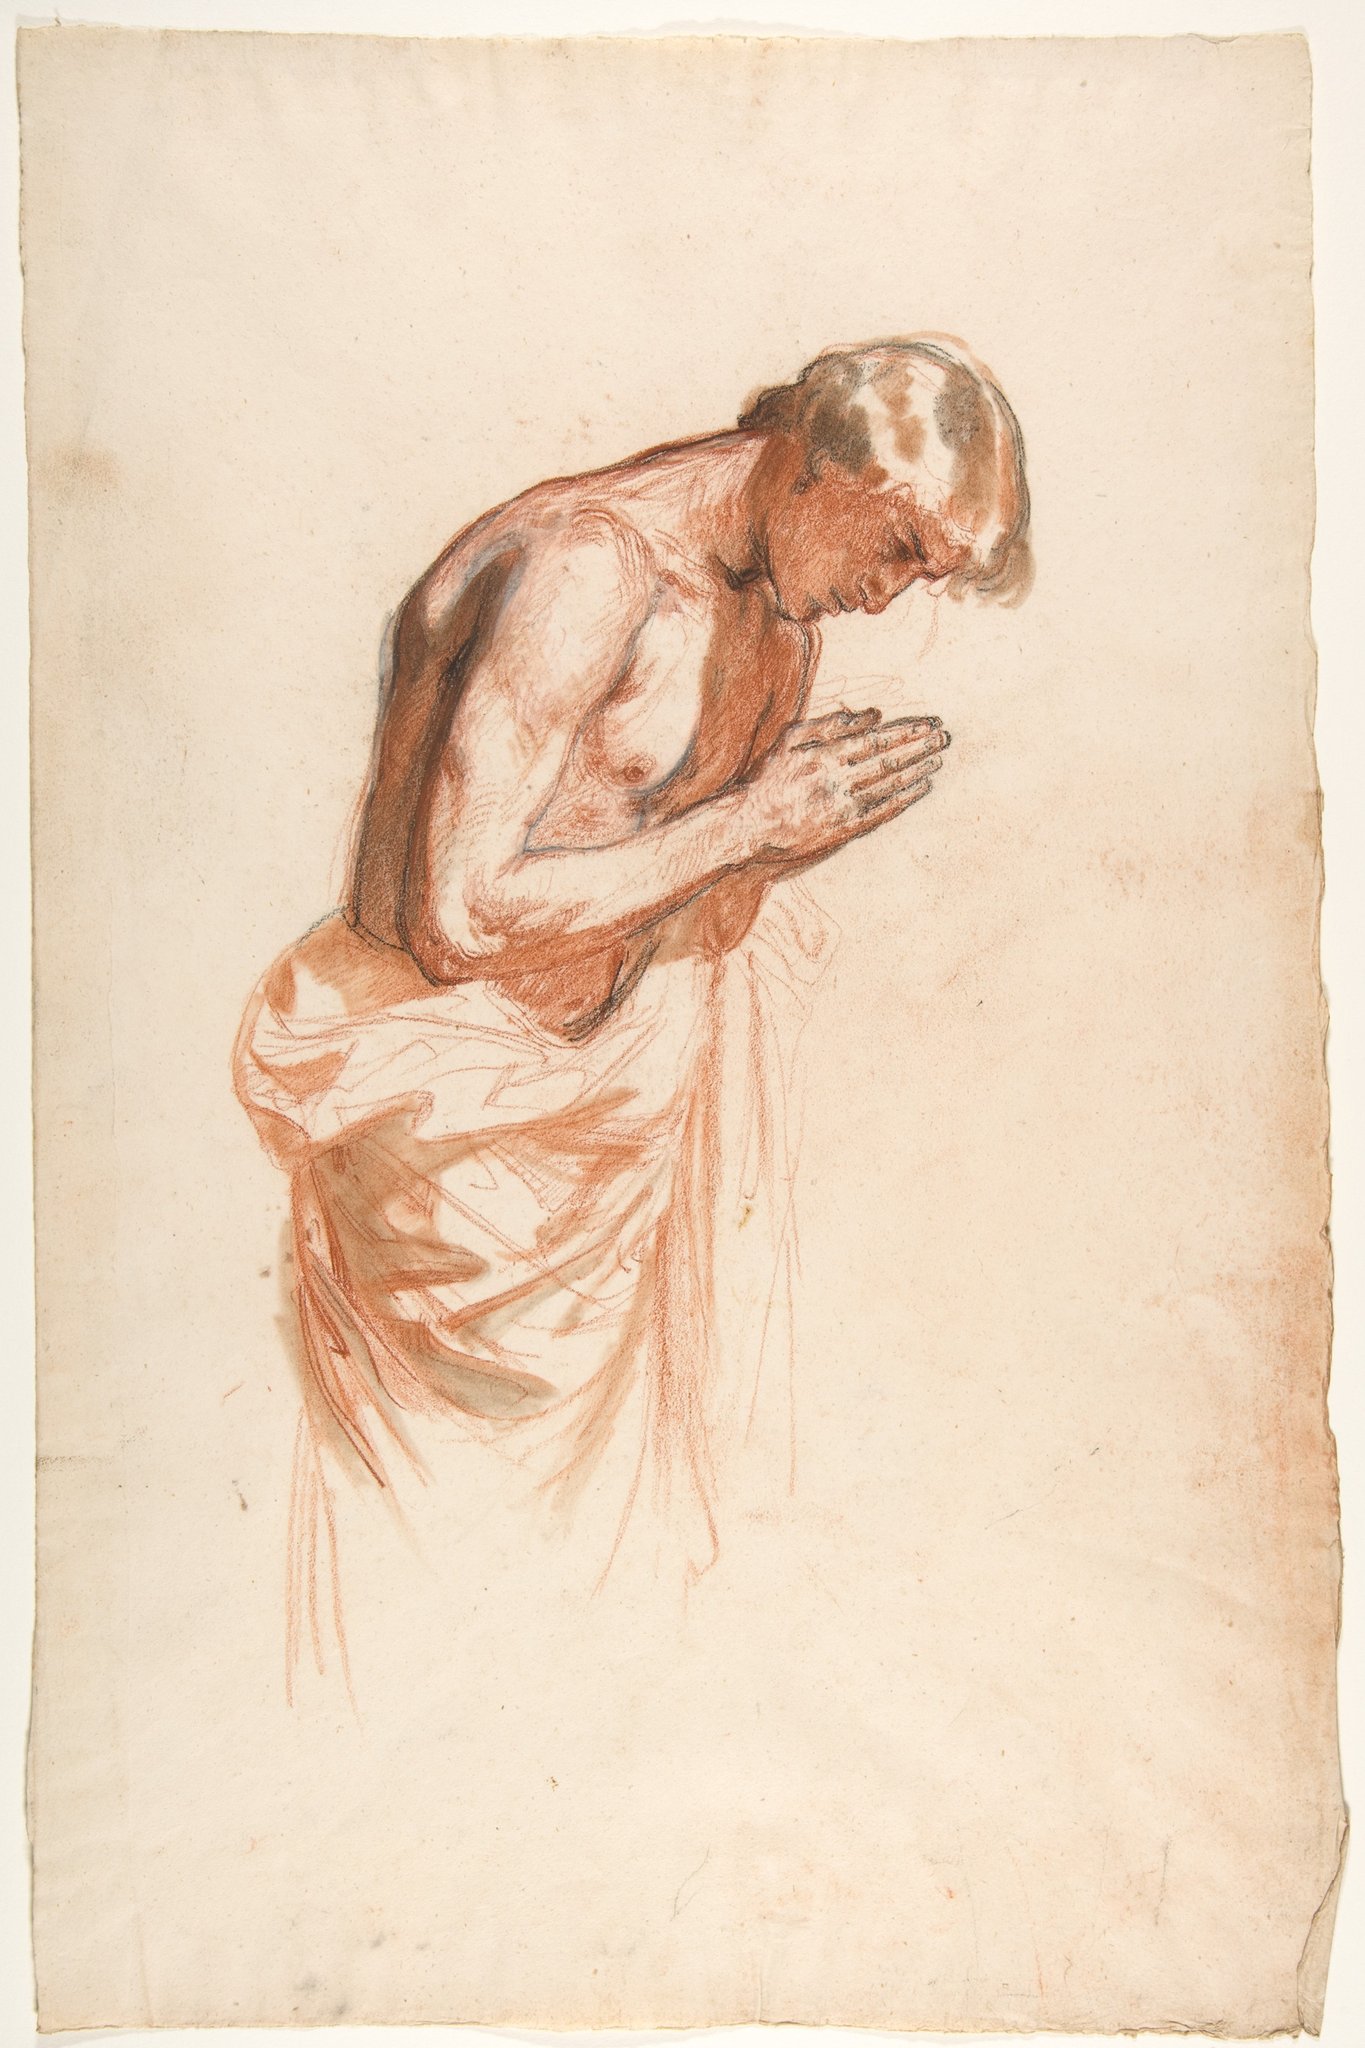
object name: drawing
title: Study for Clovis (middle register; study for wall paintings in the Chapel of Saint Remi, Sainte-Clotilde, Paris, 1858)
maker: isidore pils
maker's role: artist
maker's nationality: french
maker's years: 1813-1875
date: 1801-1900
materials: chalk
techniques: stumping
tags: men